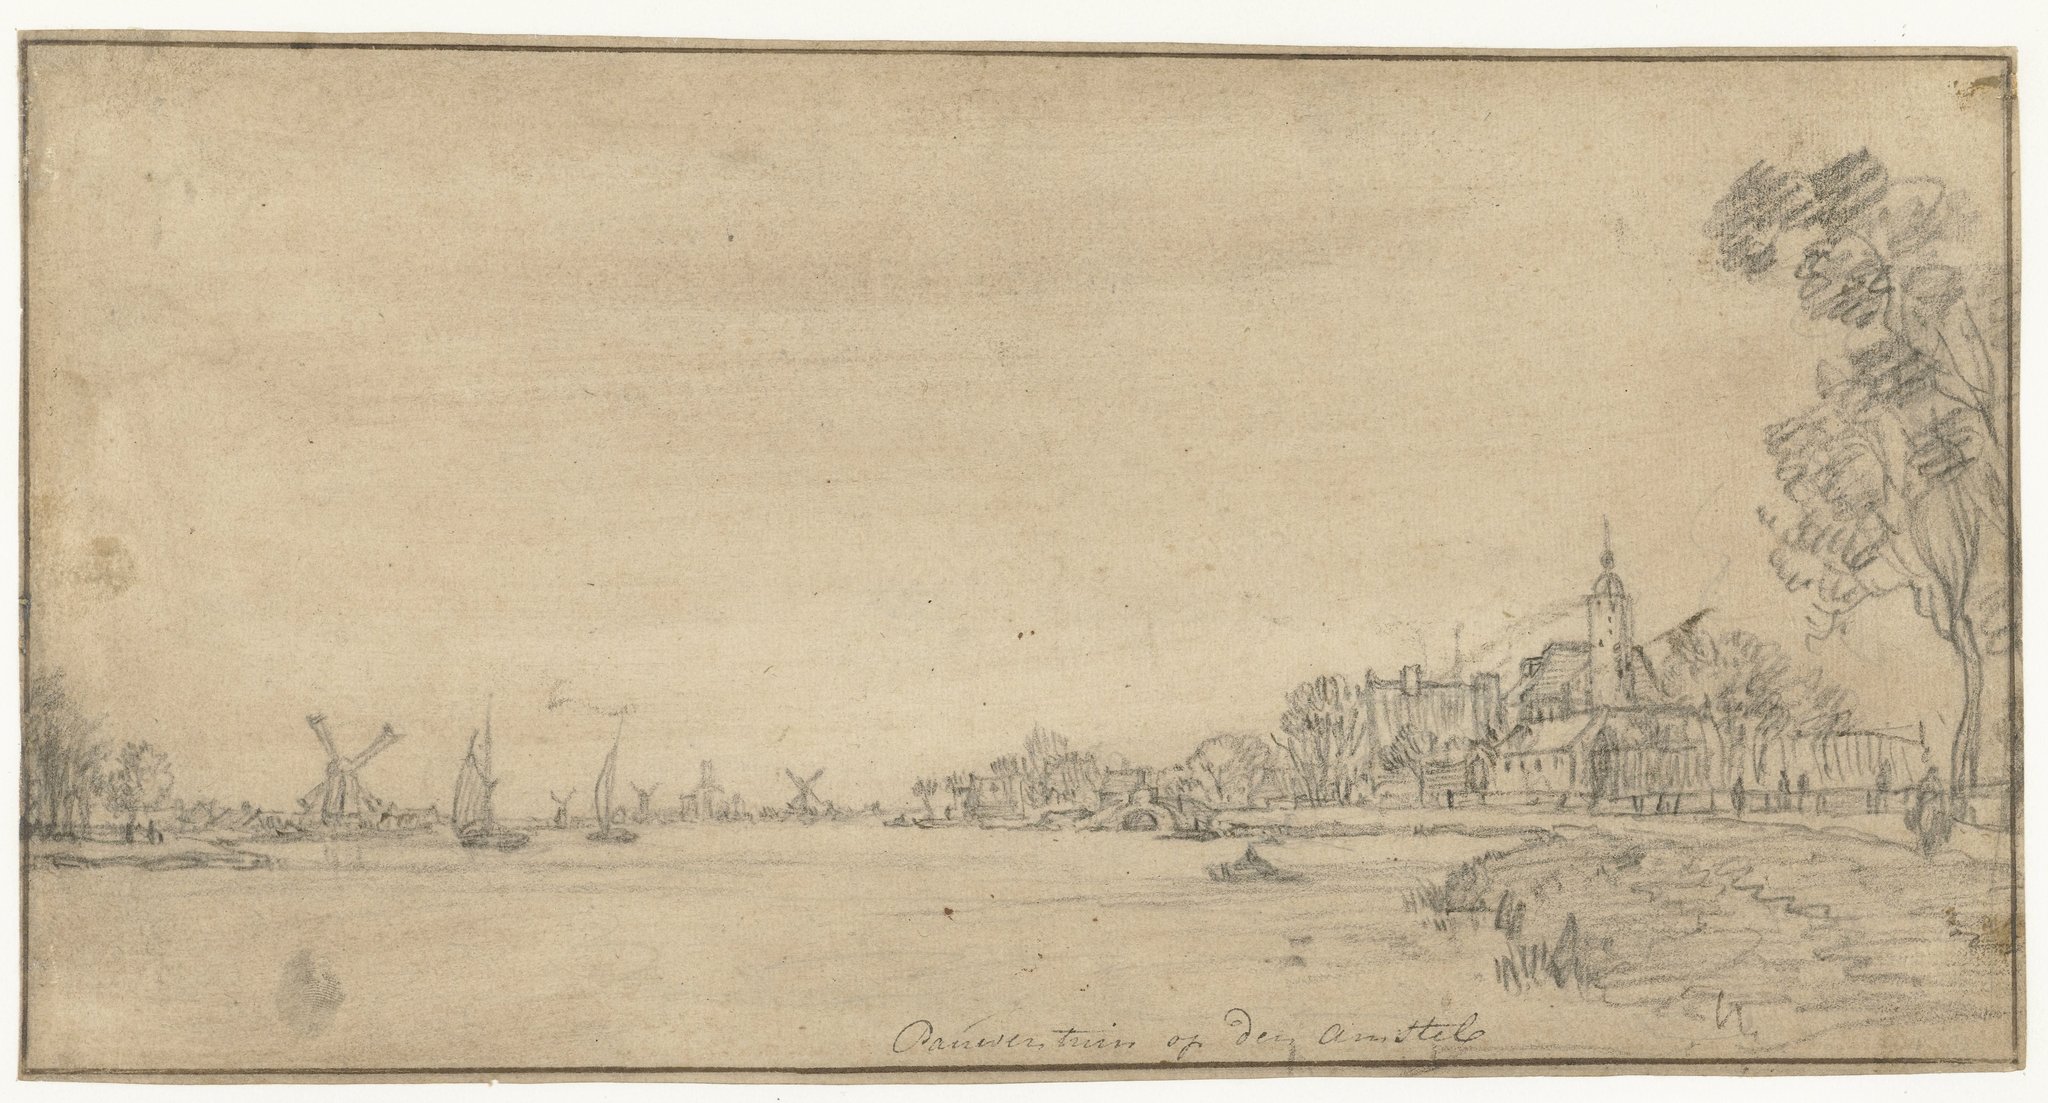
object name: drawing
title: De Pauwentuin aan de Amstel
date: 1600-1699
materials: chalk, paper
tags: river, hotel, hostelry, inn, amsterdam